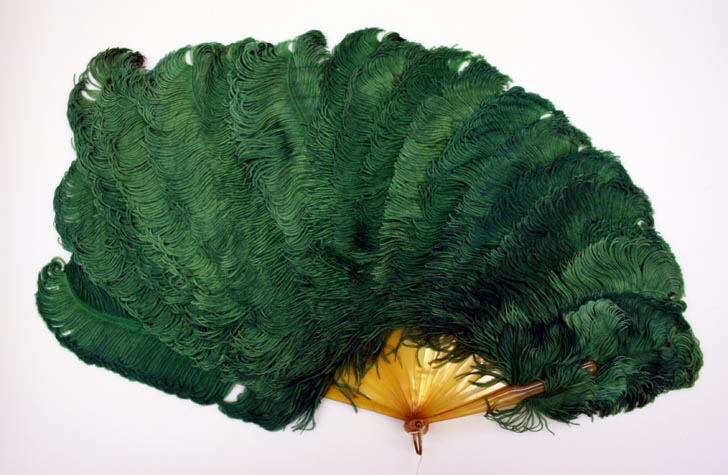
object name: fan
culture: american or european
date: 1867-1900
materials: feather, plastic